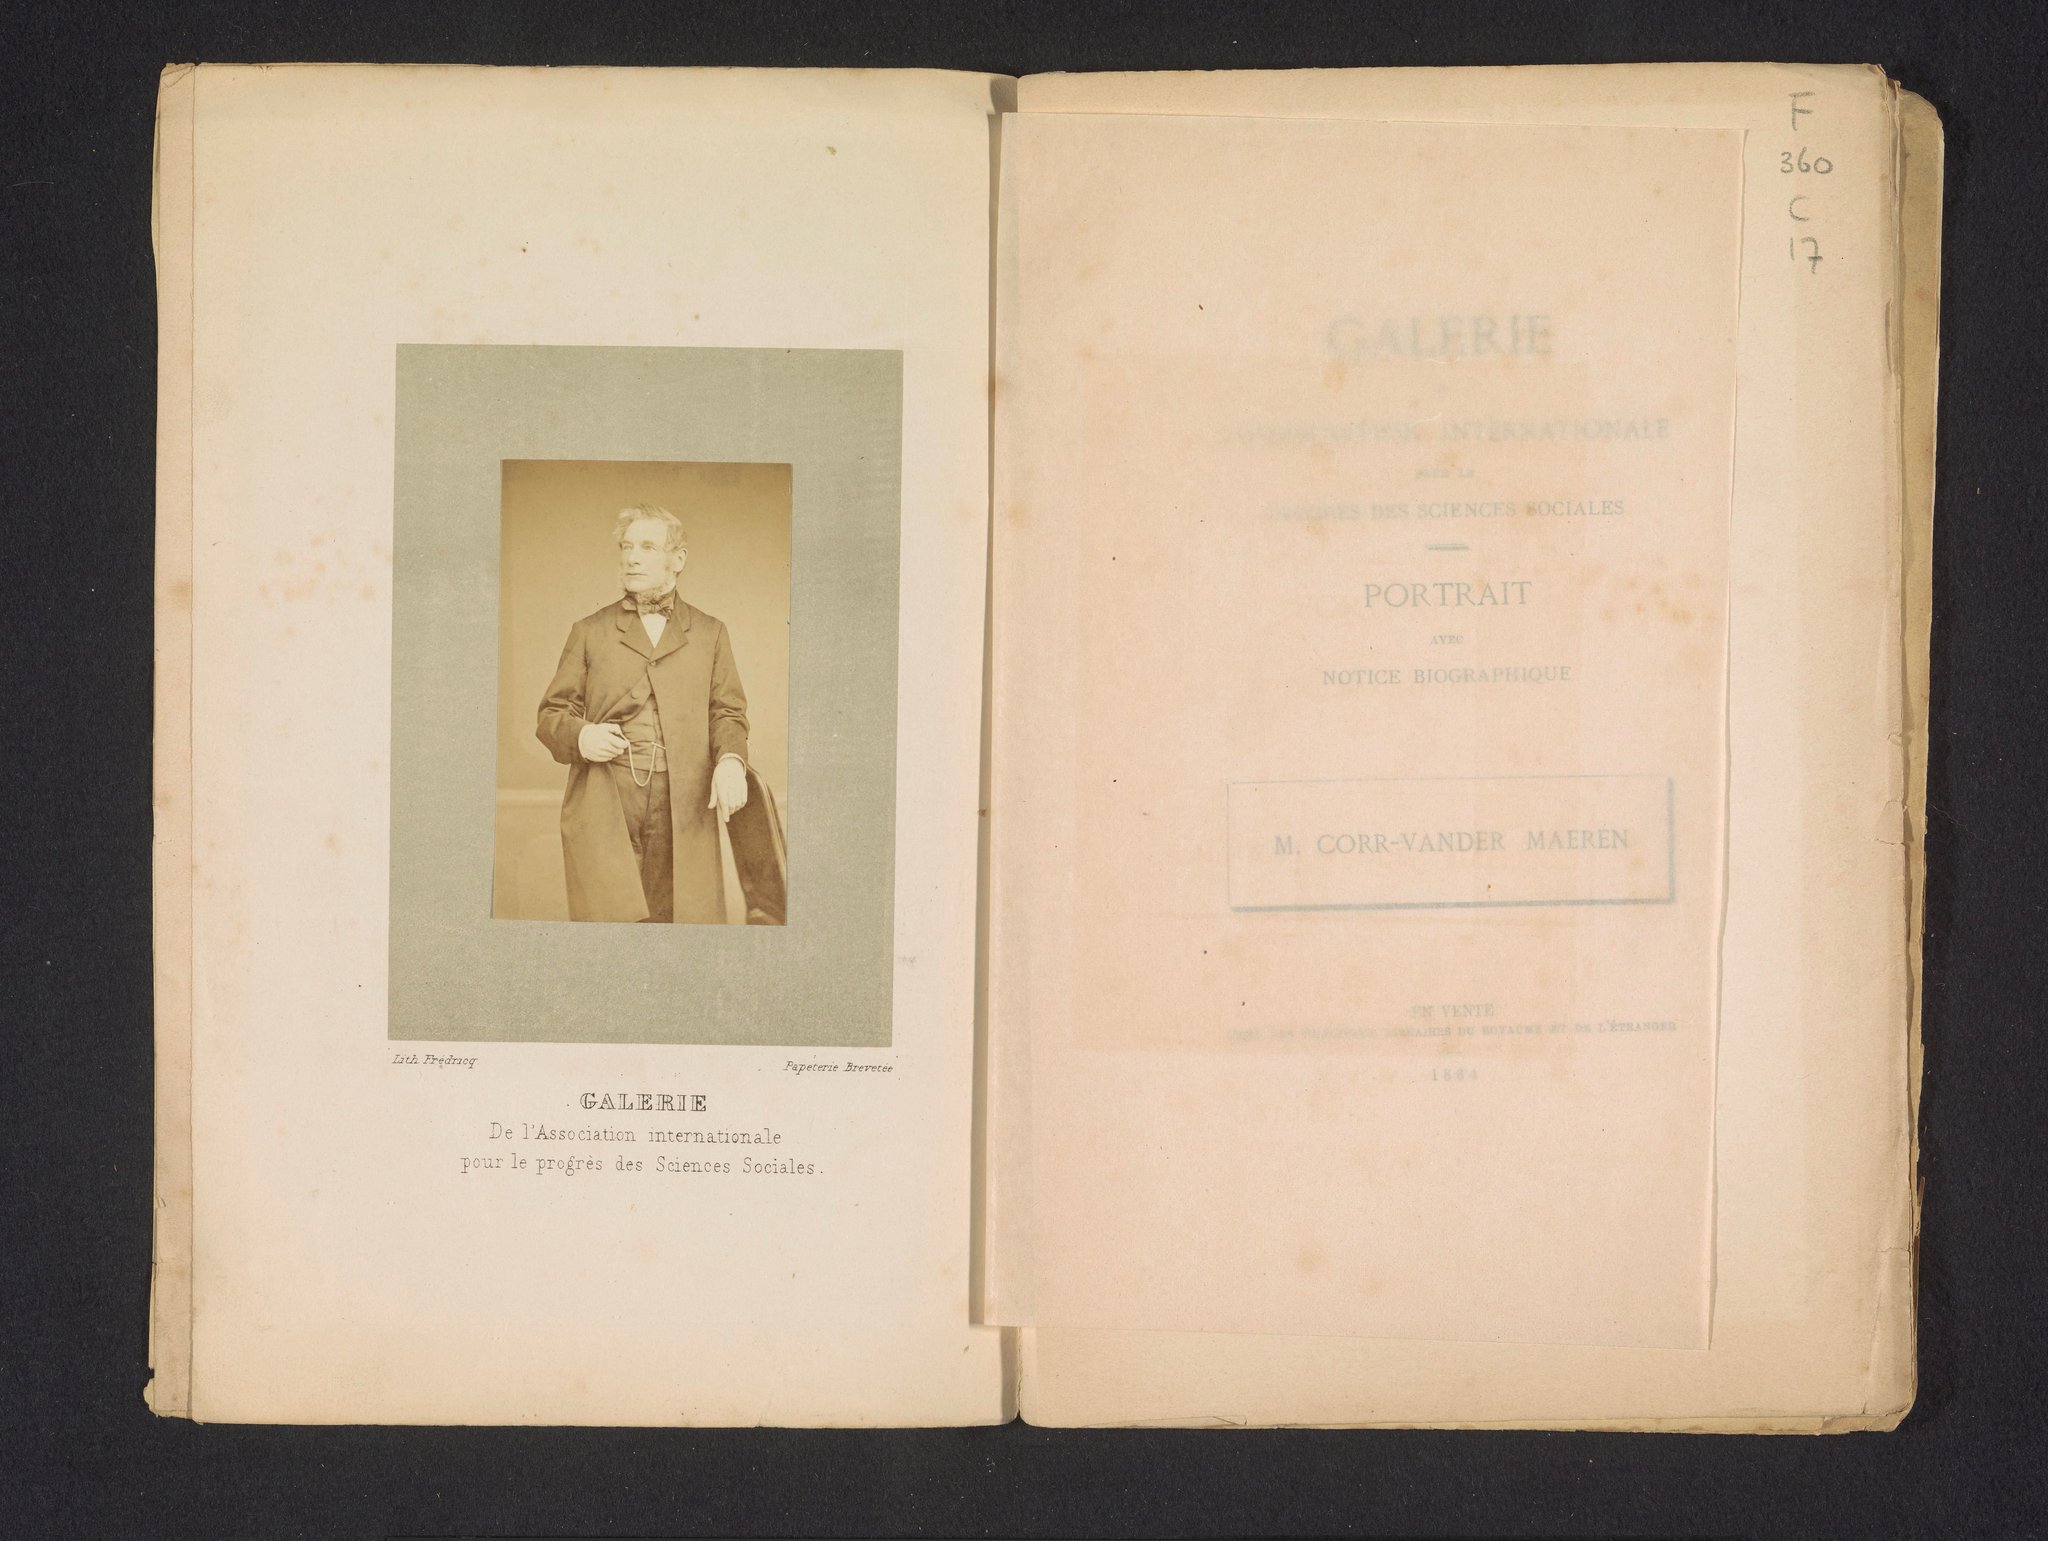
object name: photograph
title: Portret van Michel Corr-van der Maeren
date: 1859-1864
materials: photographic support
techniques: albumen print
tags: historical persons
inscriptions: inscription: ‘Galerie/ De l'Association internationale/ pour le progrès des Sciences Sociales.’, inscription: ‘Lith. Frédricq. Papeterie Brevetée’